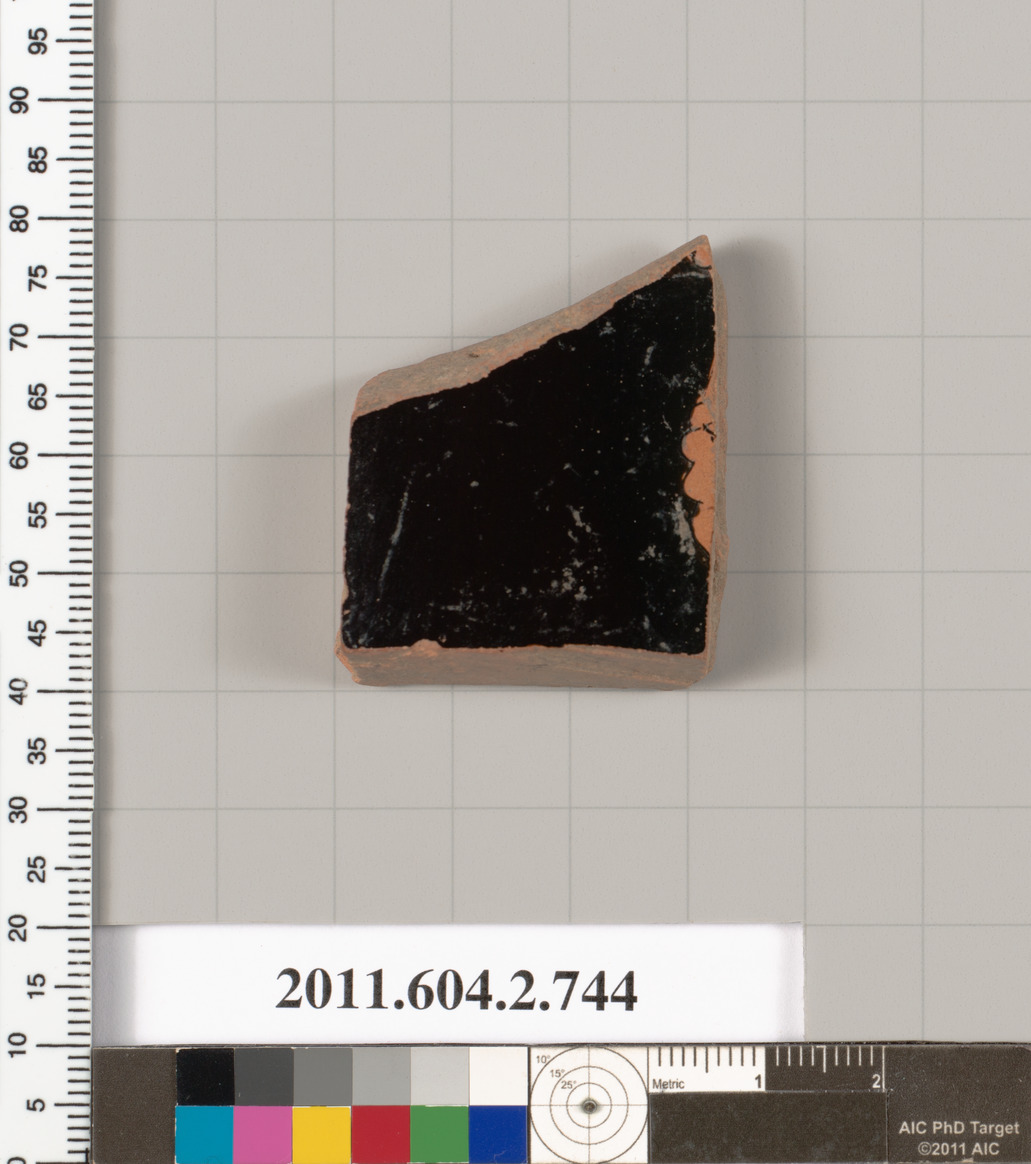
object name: calyx krater fragment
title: Terracotta fragment of a calyx-krater (bowl for mixing wine and water)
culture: greek, attic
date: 470-460 BCE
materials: terracotta